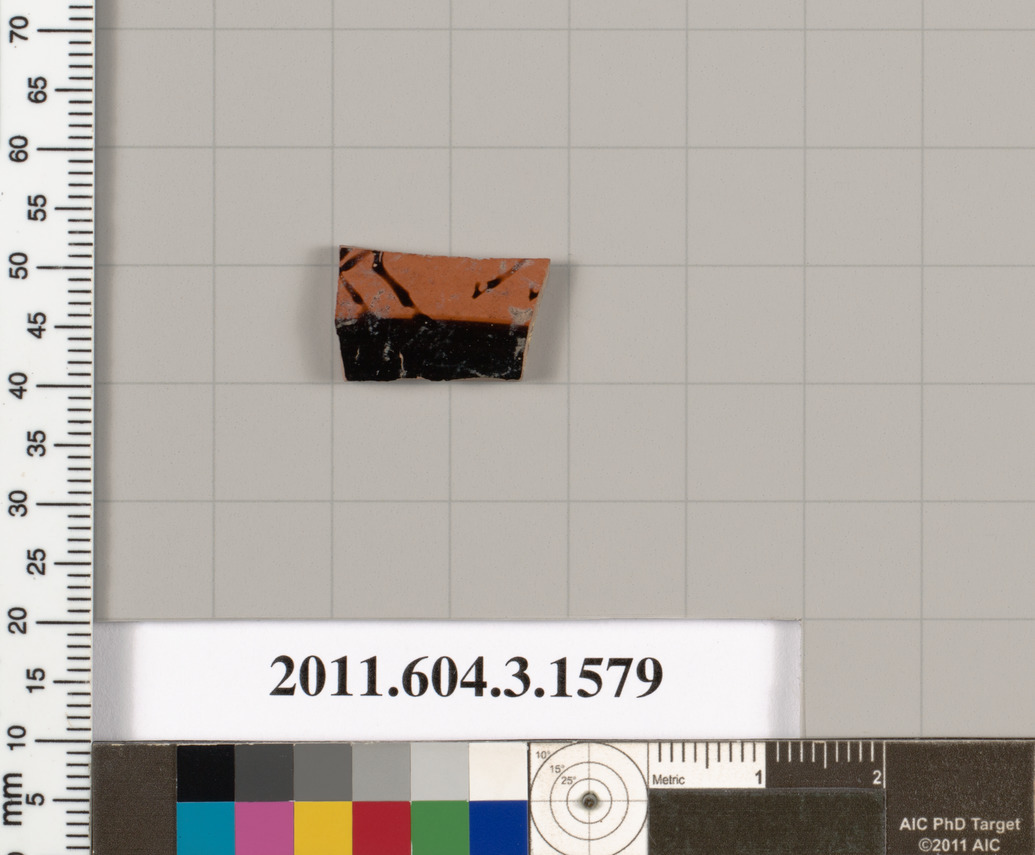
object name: kylix fragment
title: Terracotta fragment of a kylix: Band cup (drinking cup)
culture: greek, attic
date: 550-526 BCE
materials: terracotta